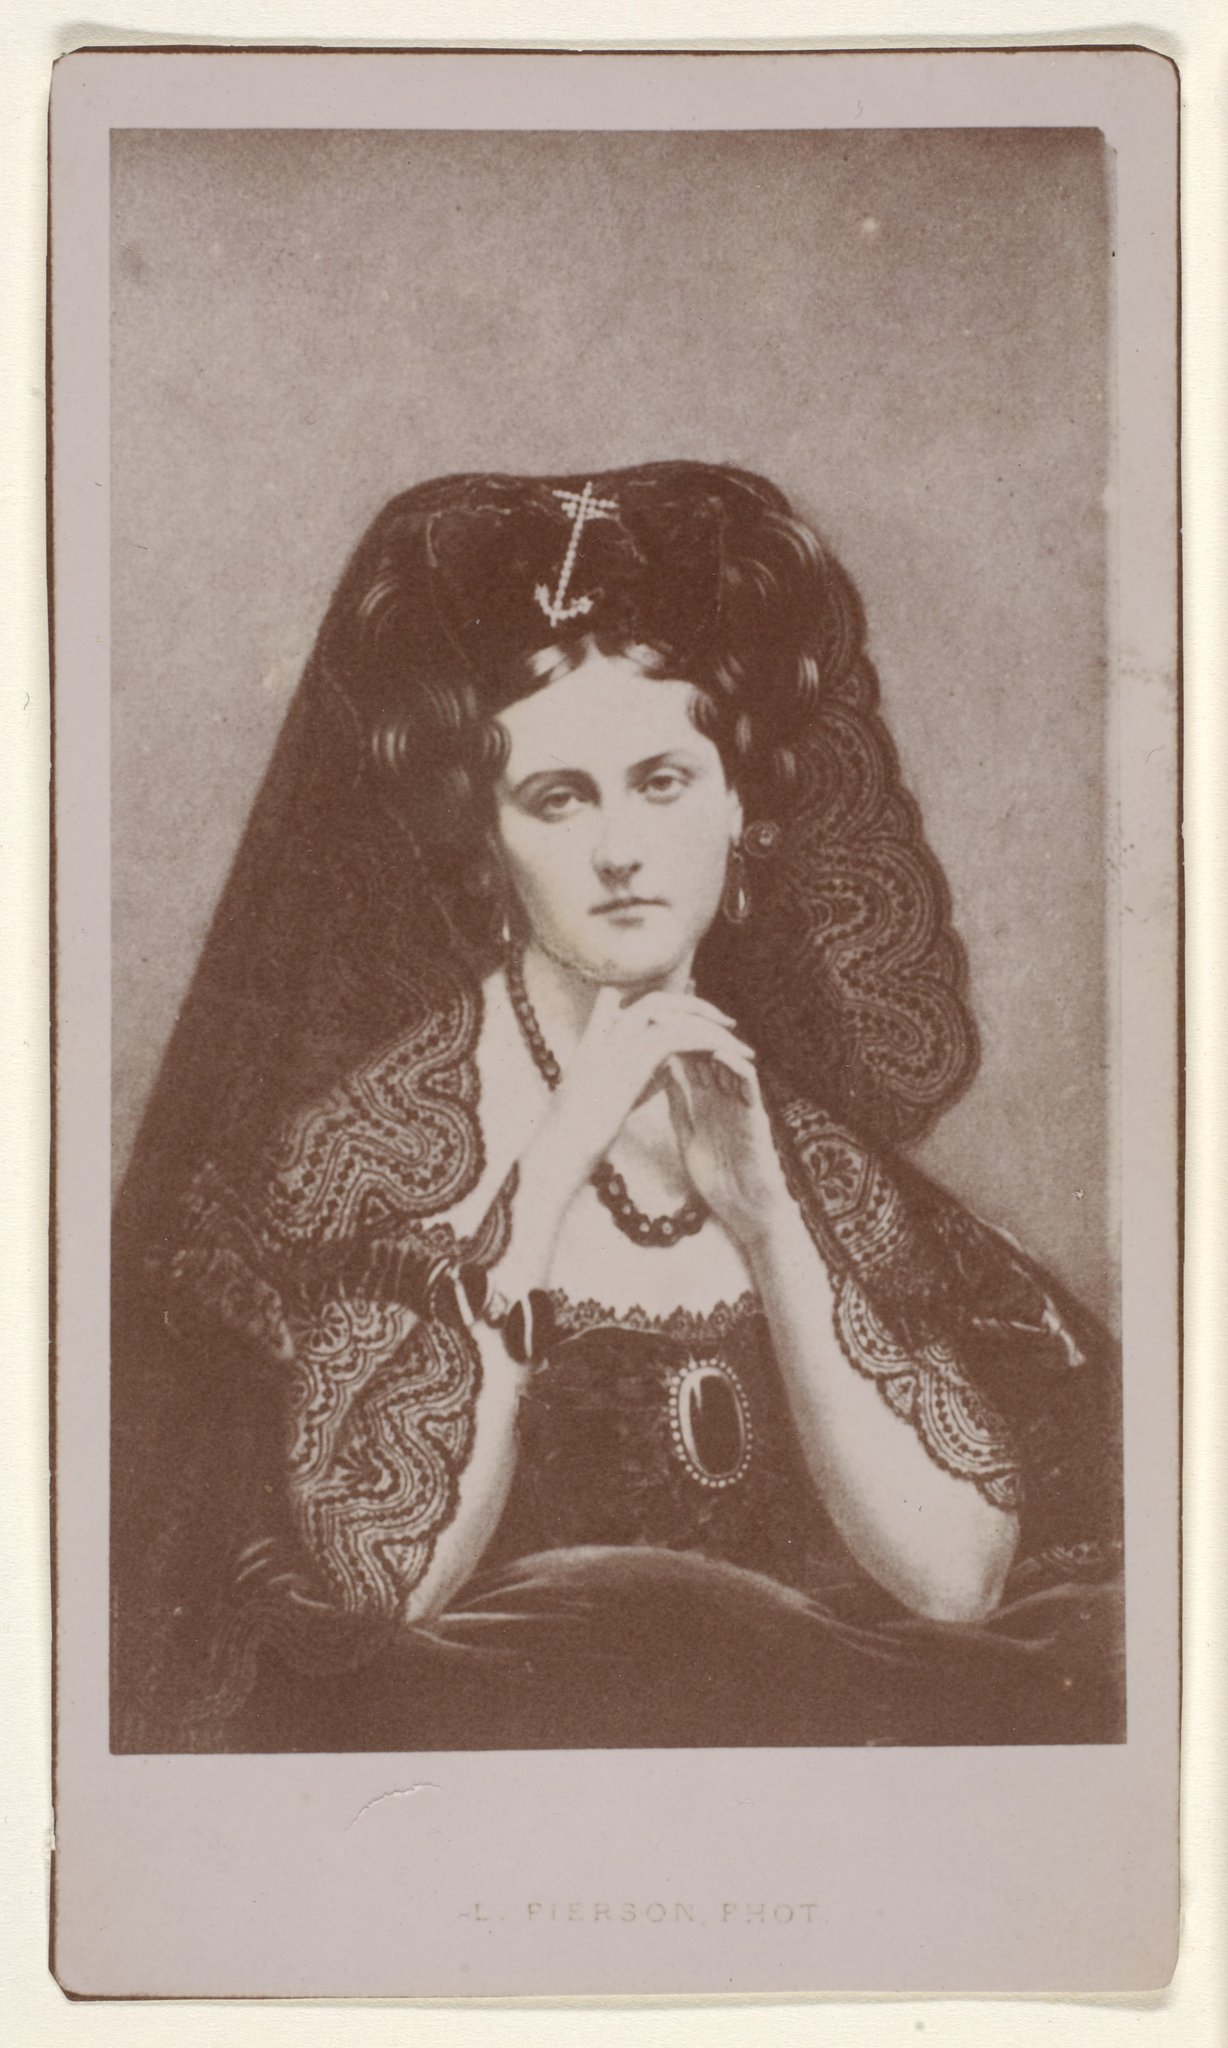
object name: photograph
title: L'Ancre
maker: pierre-louis pierson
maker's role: artist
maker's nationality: french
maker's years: 1822-1913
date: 1860-1869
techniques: albumen silver print, glass negative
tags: portraits,women